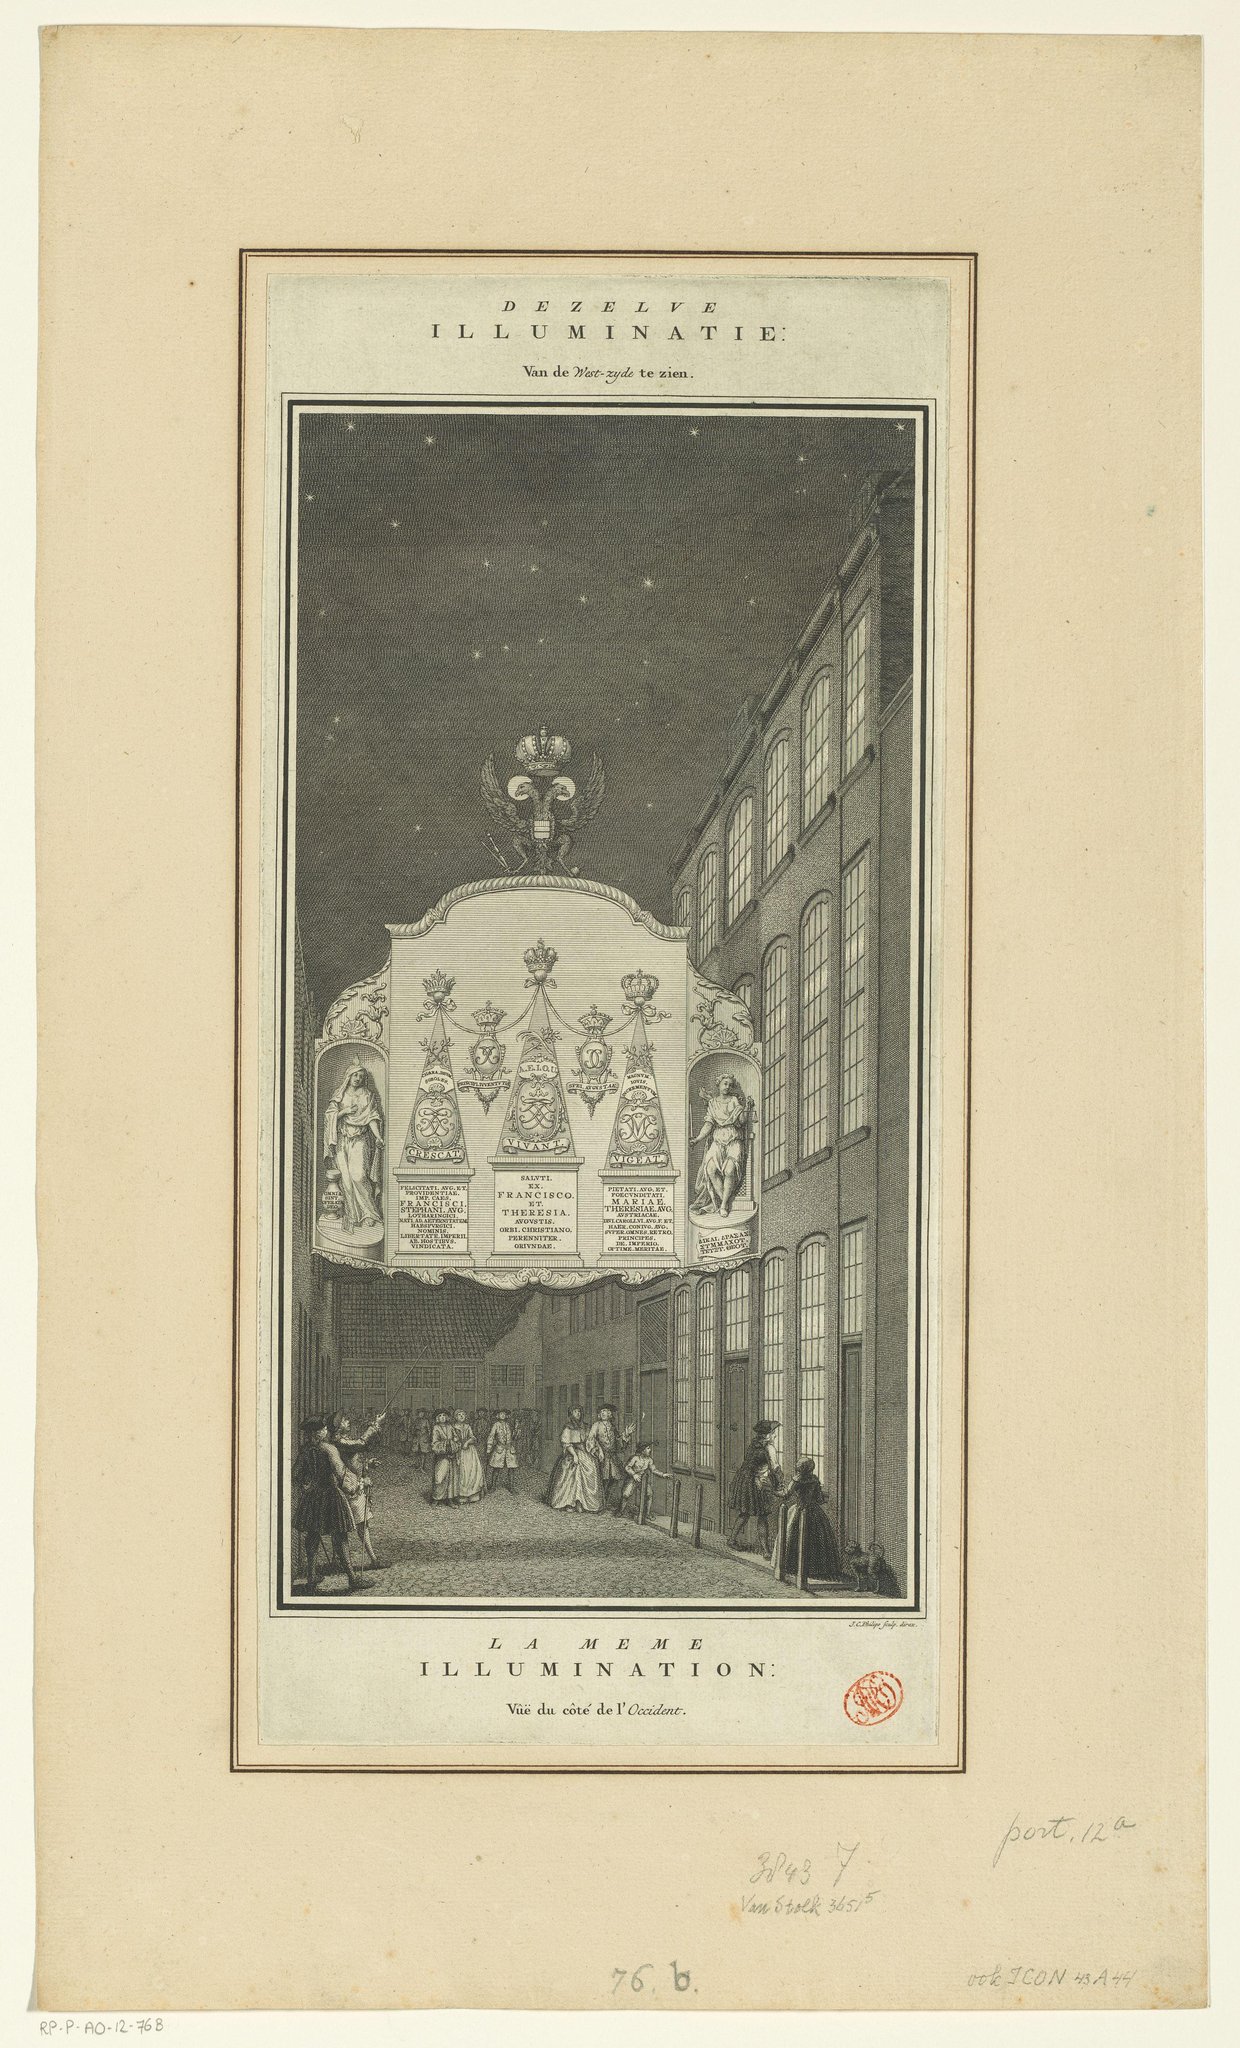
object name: print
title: Illuminatie bij het huis van Anthoni de Groot (westzijde) ter ere van de kroning van keizer Frans I Stefan, 1745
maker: jan caspar philips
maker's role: draughtsman, print maker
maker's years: 1700-1775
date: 1745-1747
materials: paper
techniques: engraving, etching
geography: northern netherlands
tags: anthoni de groot, frans i stefan (duits keizer), public festivities (+ decorated staff, portable structure ~ festive activities), coronation of a ruler, bonfire, fire-works (+ illumination, fire-works ~ festive activities), the hague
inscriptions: collector's mark: Lugt 195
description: Illuminatie ter gelegenheid van de kroning van Frans I Stefan tot keizer op 4-6 oktober 1745 opgericht voor het huis van de uitgever Anthoni de Groot te Den Haag, gezien vanuit de westzijde. Een groot verlicht bord hangend over de straat met obelisken en allegorische figuren.